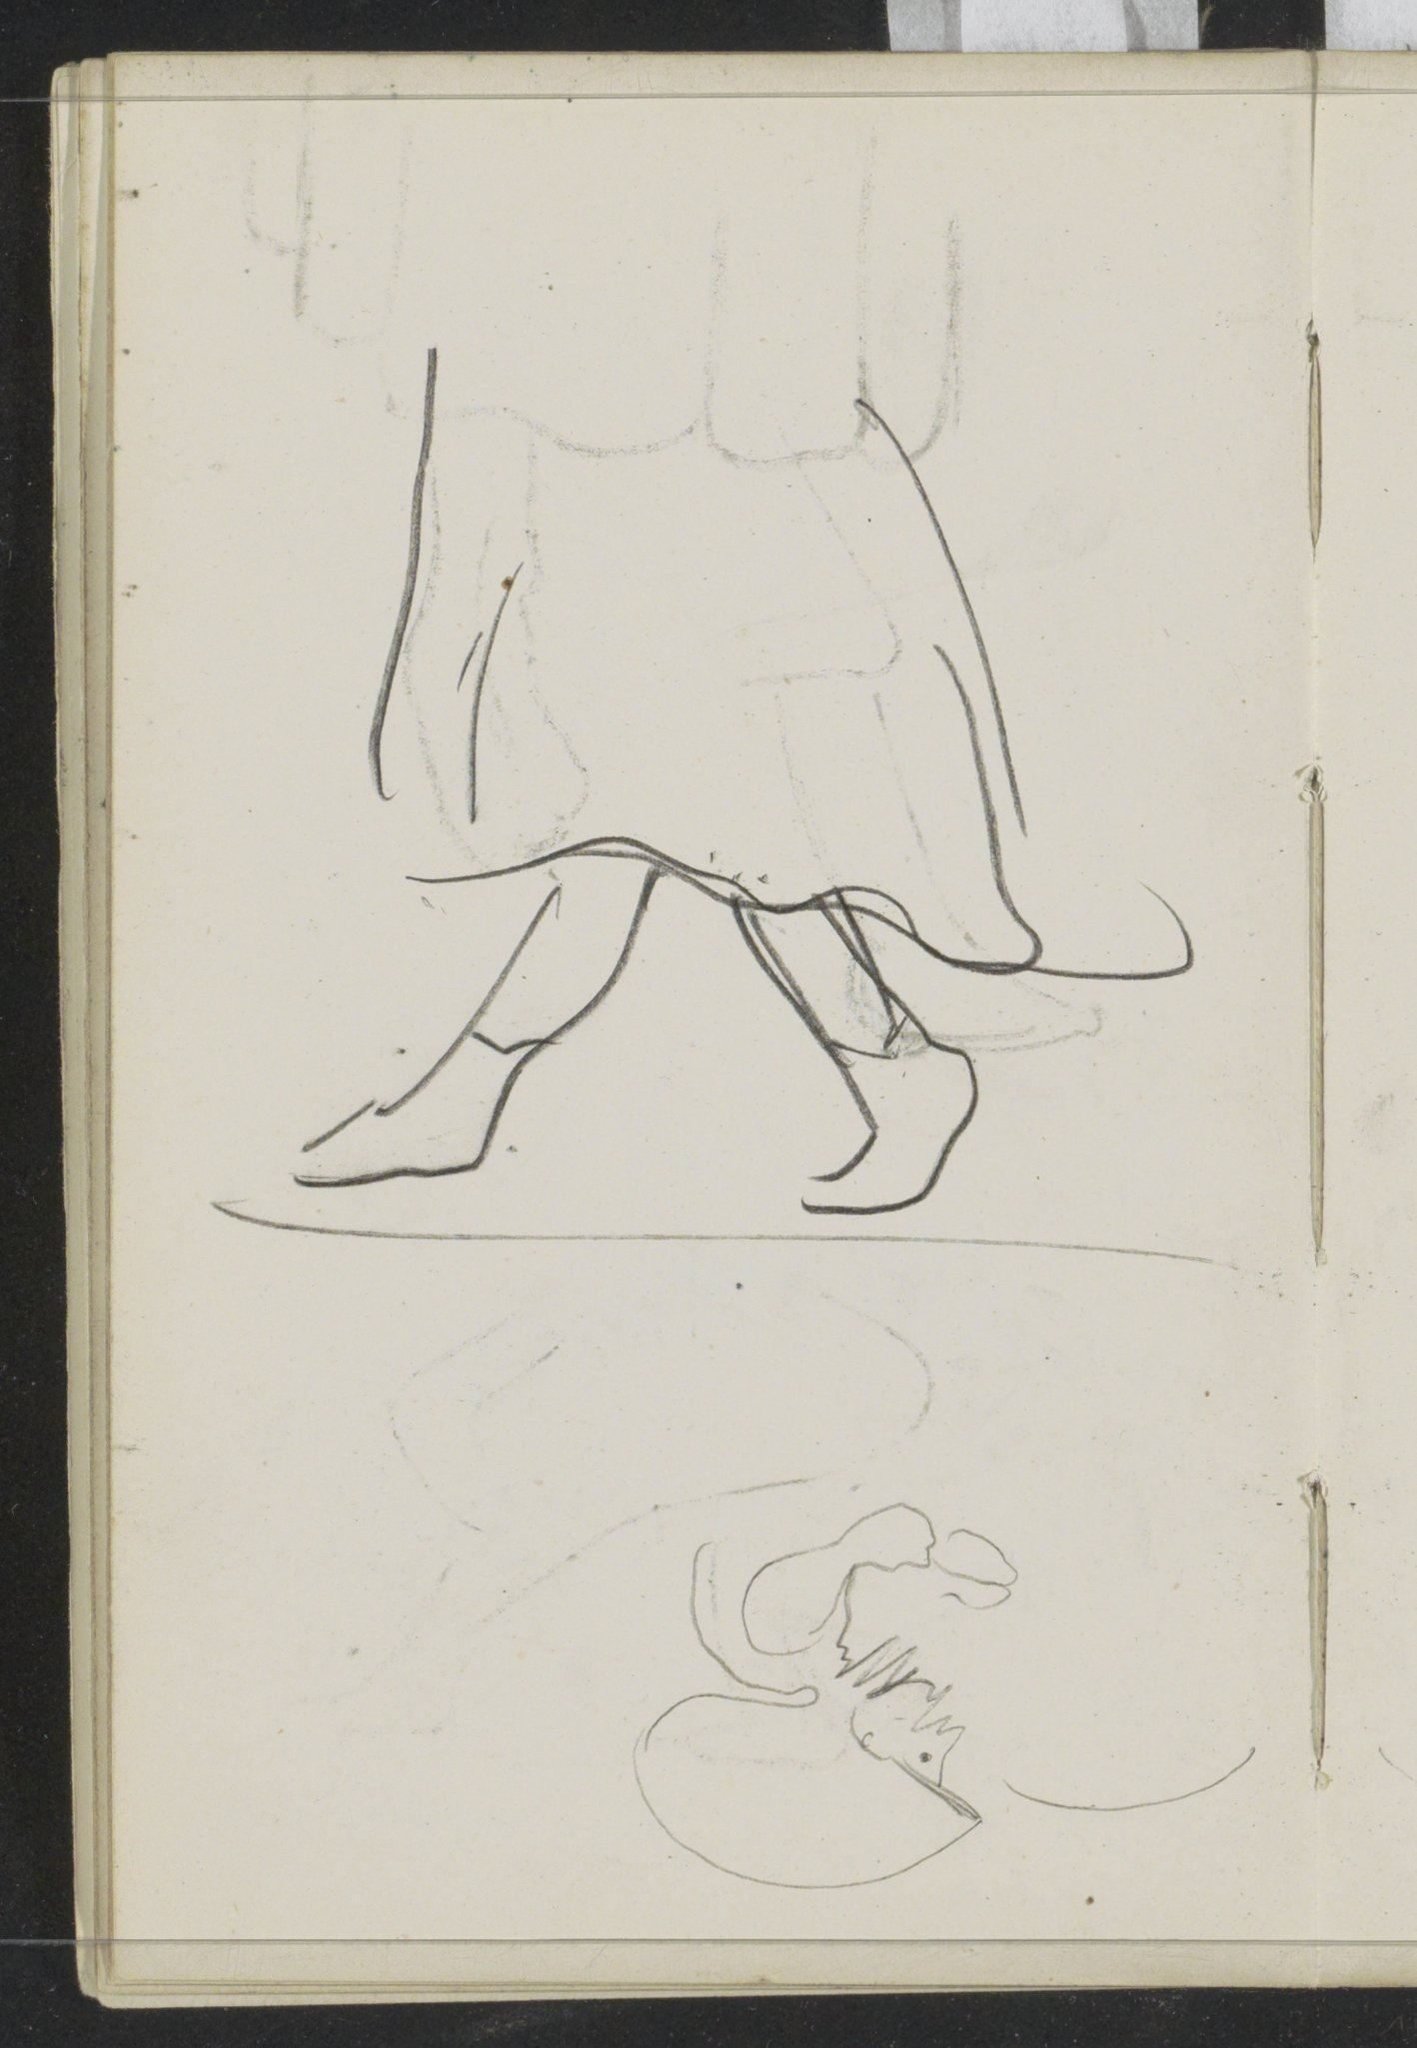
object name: sketchbook leaf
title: Voeten onder een rok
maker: carel adolph lion cachet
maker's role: draughtsman, print maker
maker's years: 1864-1945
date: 1874-1945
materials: chalk, paper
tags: head (human), skirt, legs, walking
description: Tevens een studie van een kop. Blad 21 verso uit een schetsboek met 41 bladen.